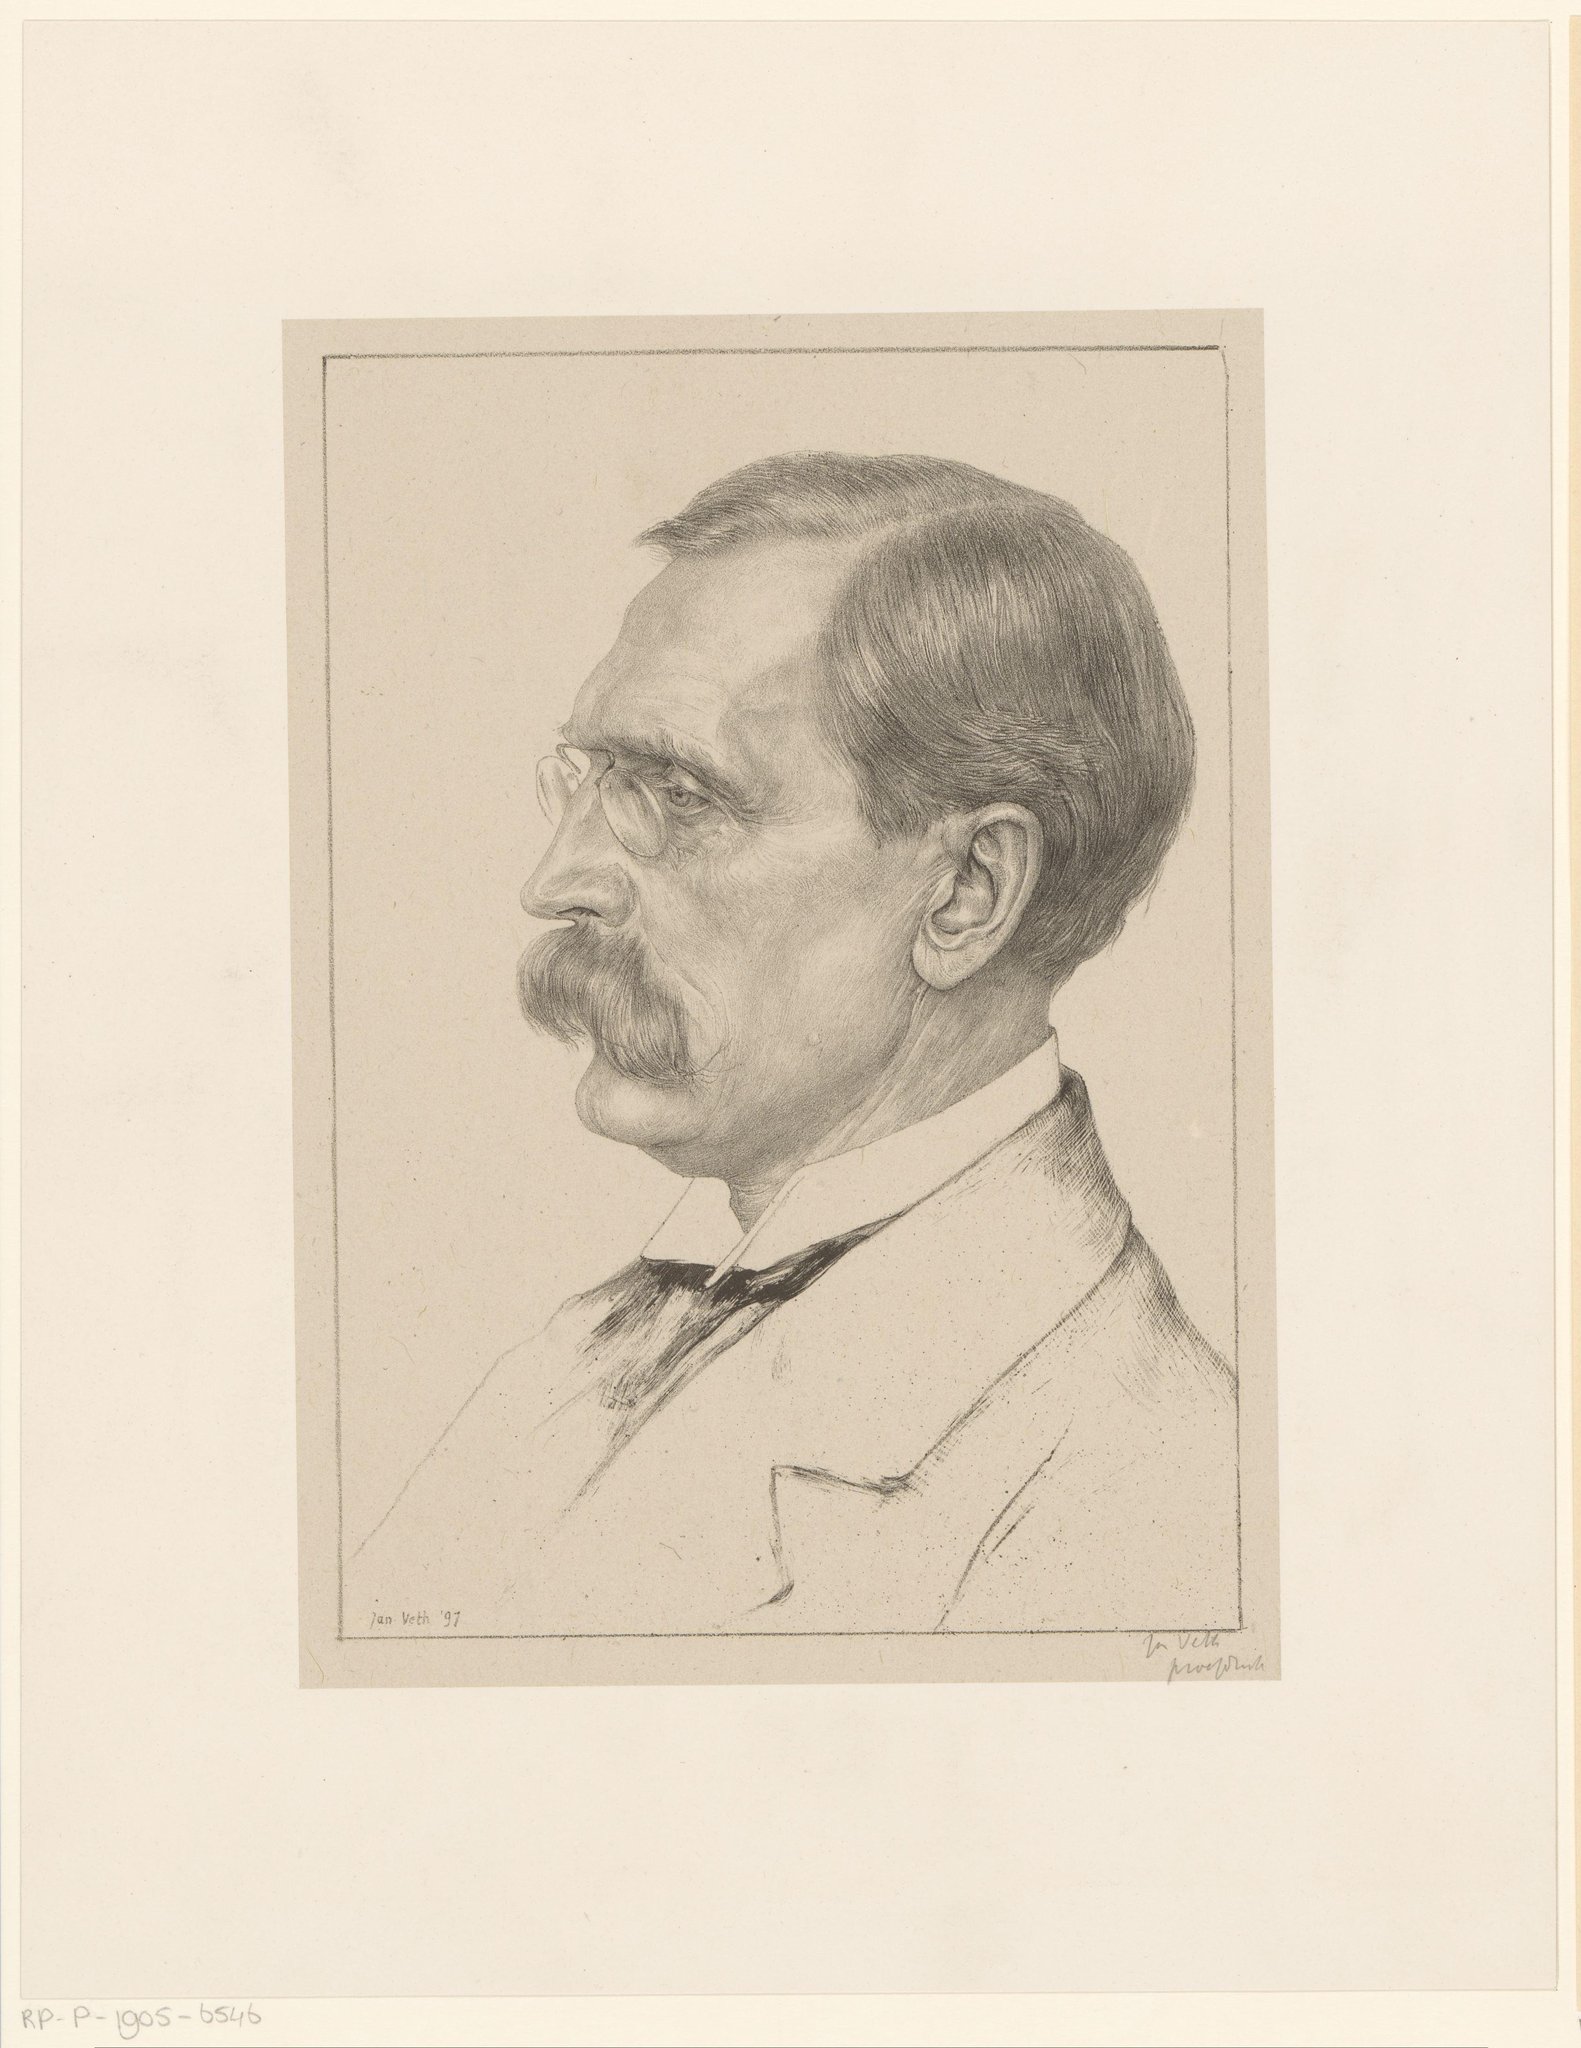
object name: print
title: Portret van Wilhelm von Bode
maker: jan veth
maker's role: designer, draughtsman, painter, print maker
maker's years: 1864-1925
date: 1897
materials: paper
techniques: lithograph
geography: netherlands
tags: historical persons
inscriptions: inscription: ‘Jan Veth / proefdruk’, collector's mark: Lugt 2228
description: Dit portret werd uitgegeven als bijvoegsel bij De Kroniek op 23 oktober 1898.